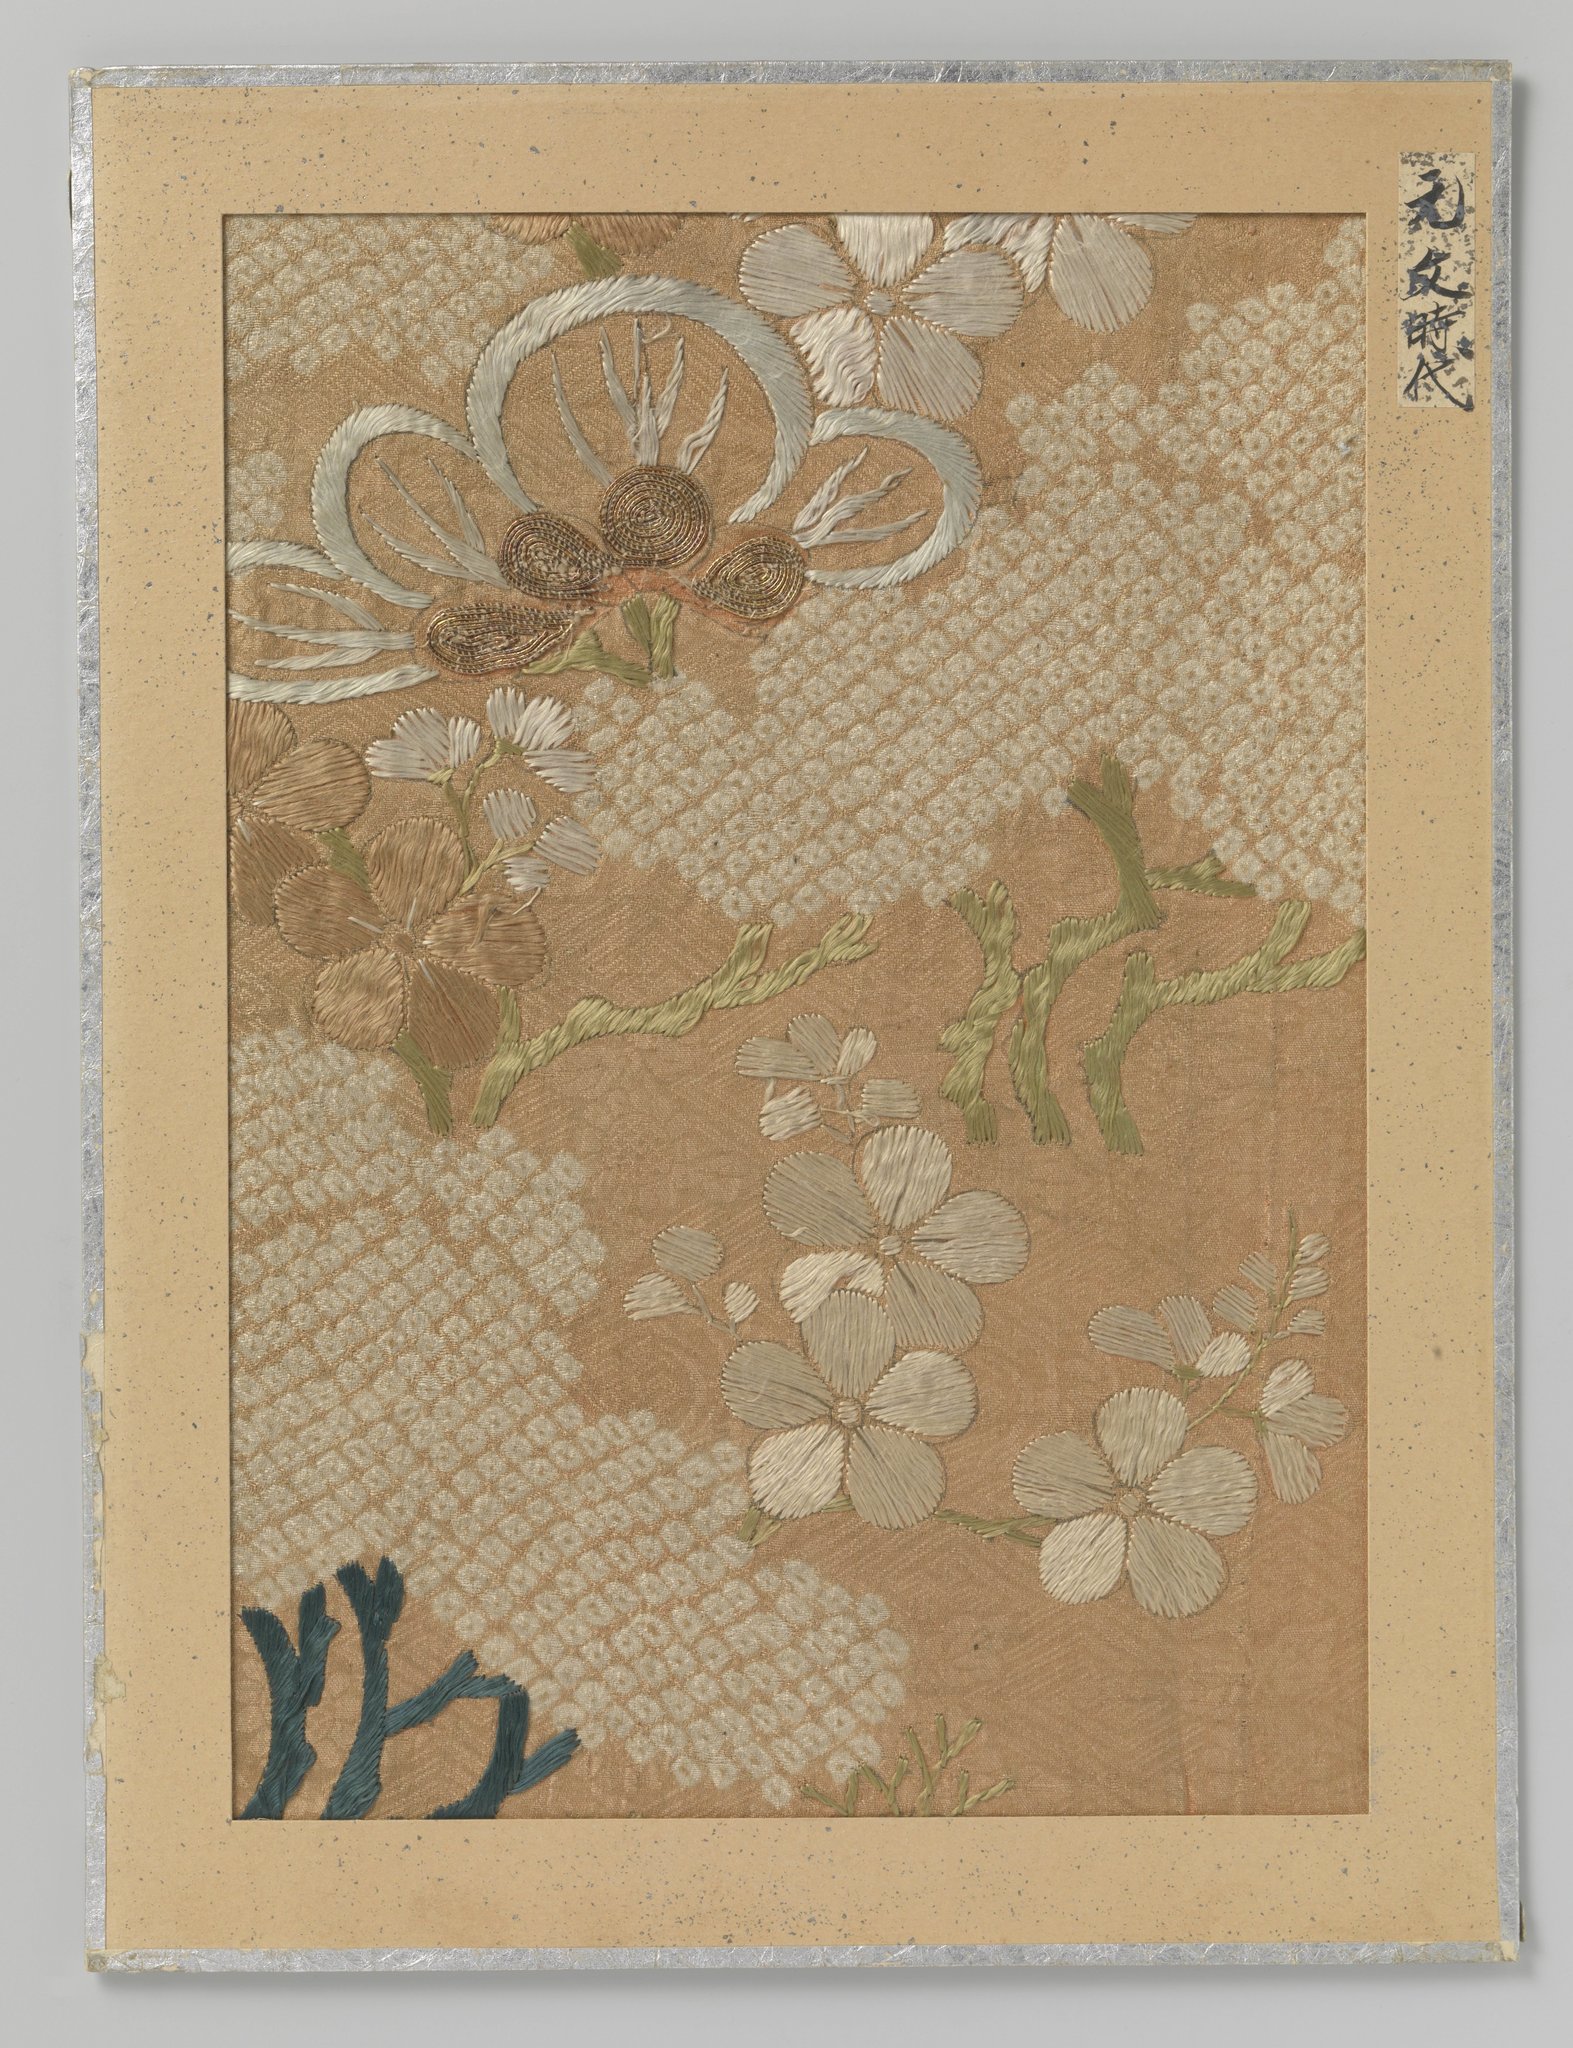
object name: fragment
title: Fragment textiel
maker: Anonymous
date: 1736-1740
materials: silk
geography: japan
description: Textielfragment, borduursel en druk van bomen en bloemen op okerkleurige damast.